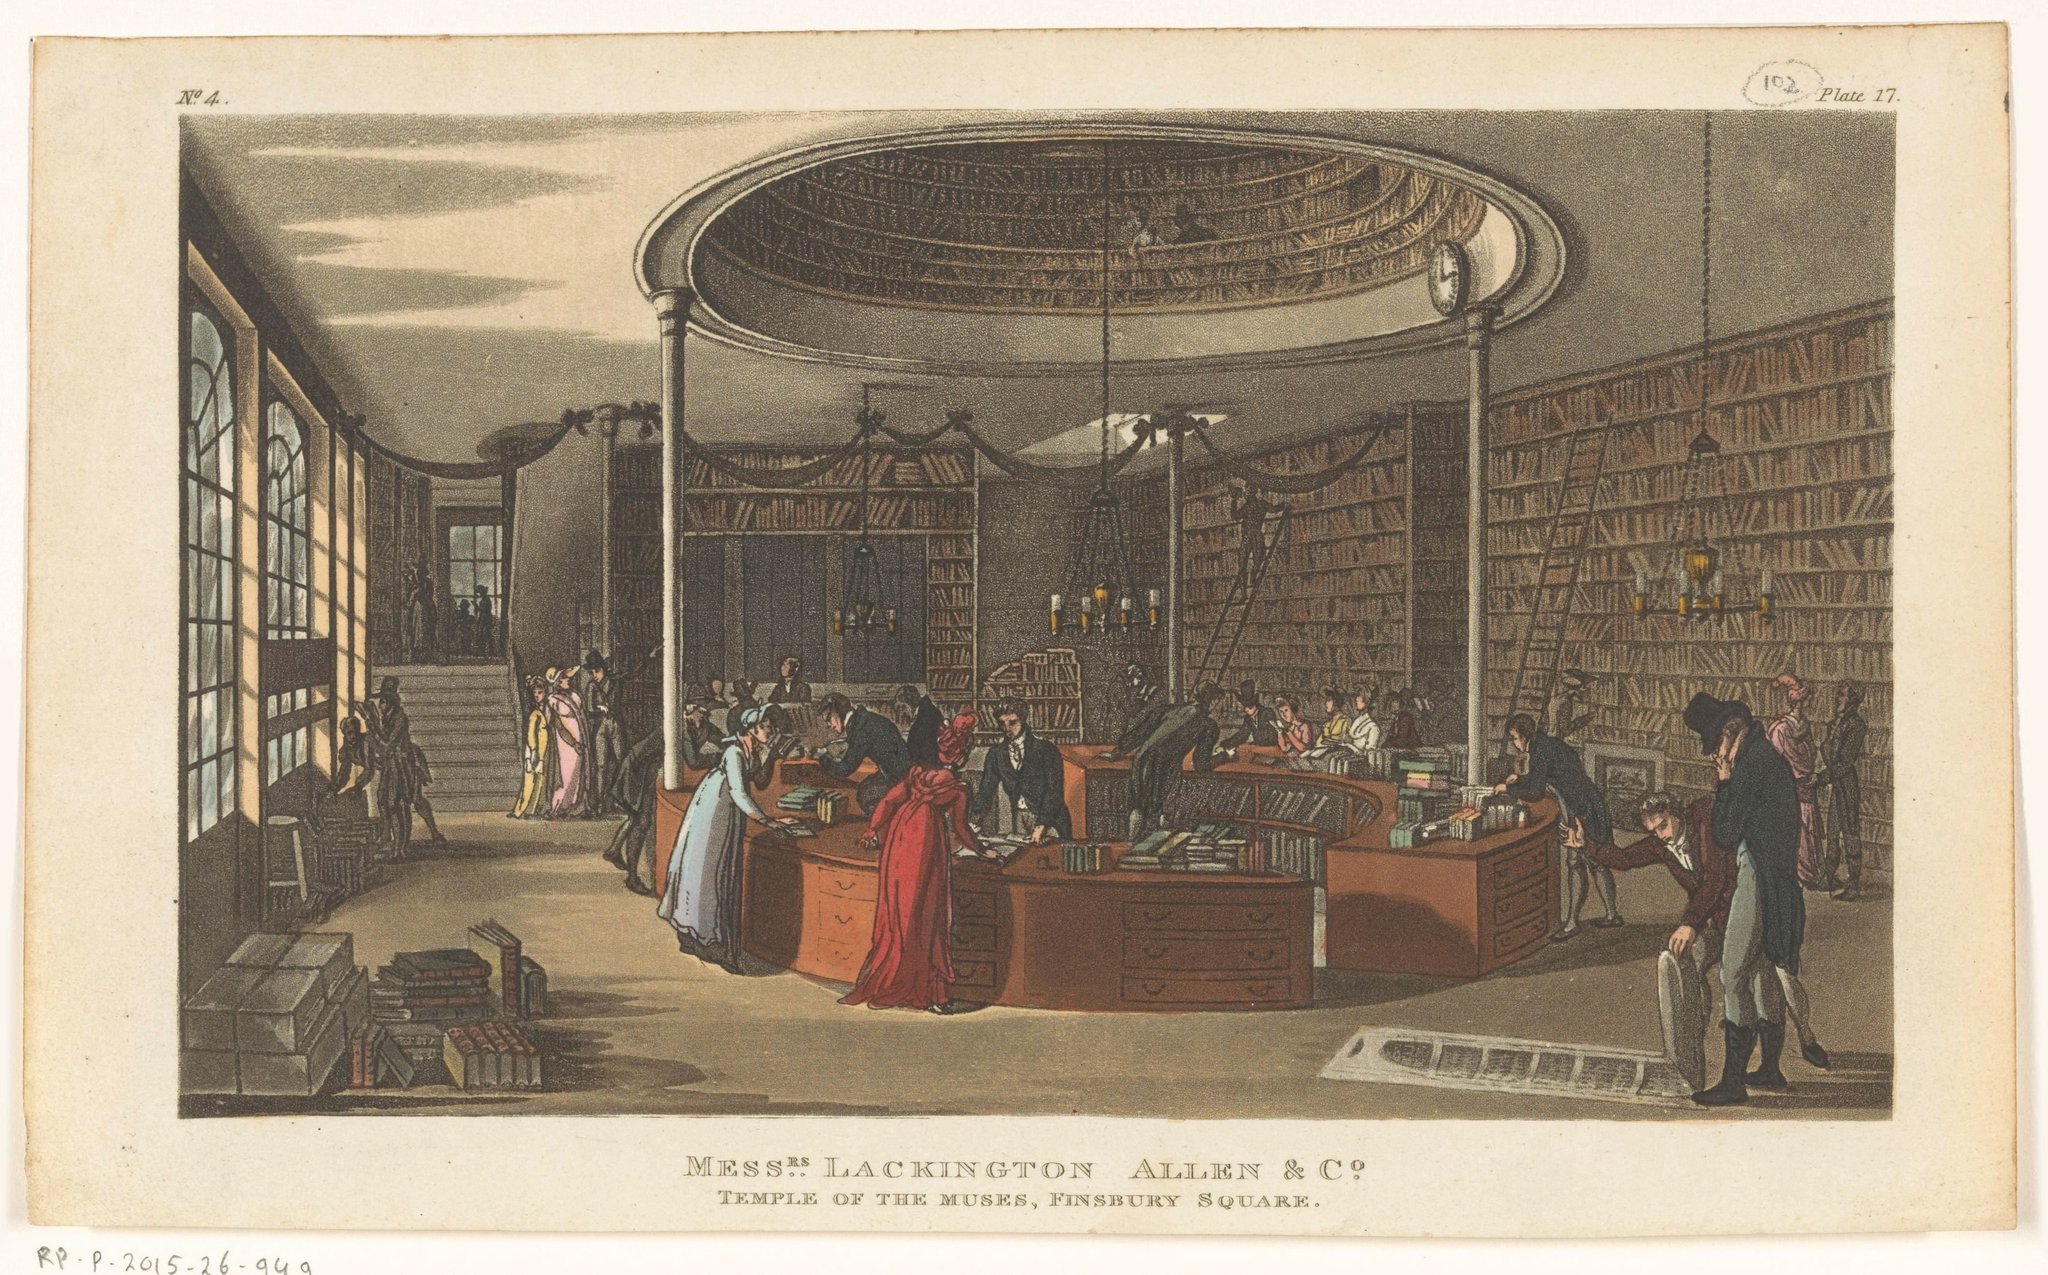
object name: print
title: Interieur van de boekhandel van Lackington, Allen & Co. te Londen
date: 1809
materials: paper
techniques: aquatint, etching, hand coloring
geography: london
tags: bookshelves, book-shop, bookseller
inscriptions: collector's mark: Lugt 2228, collector's mark: Lugt 4779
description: Interieur van de boekhandel met in het midden een ronde toonbank onder een koepel. Op de voorgrond bekijken twee mannen een prent. Rechtsboven genummerd: Plate 17; linksboven: No. 4.